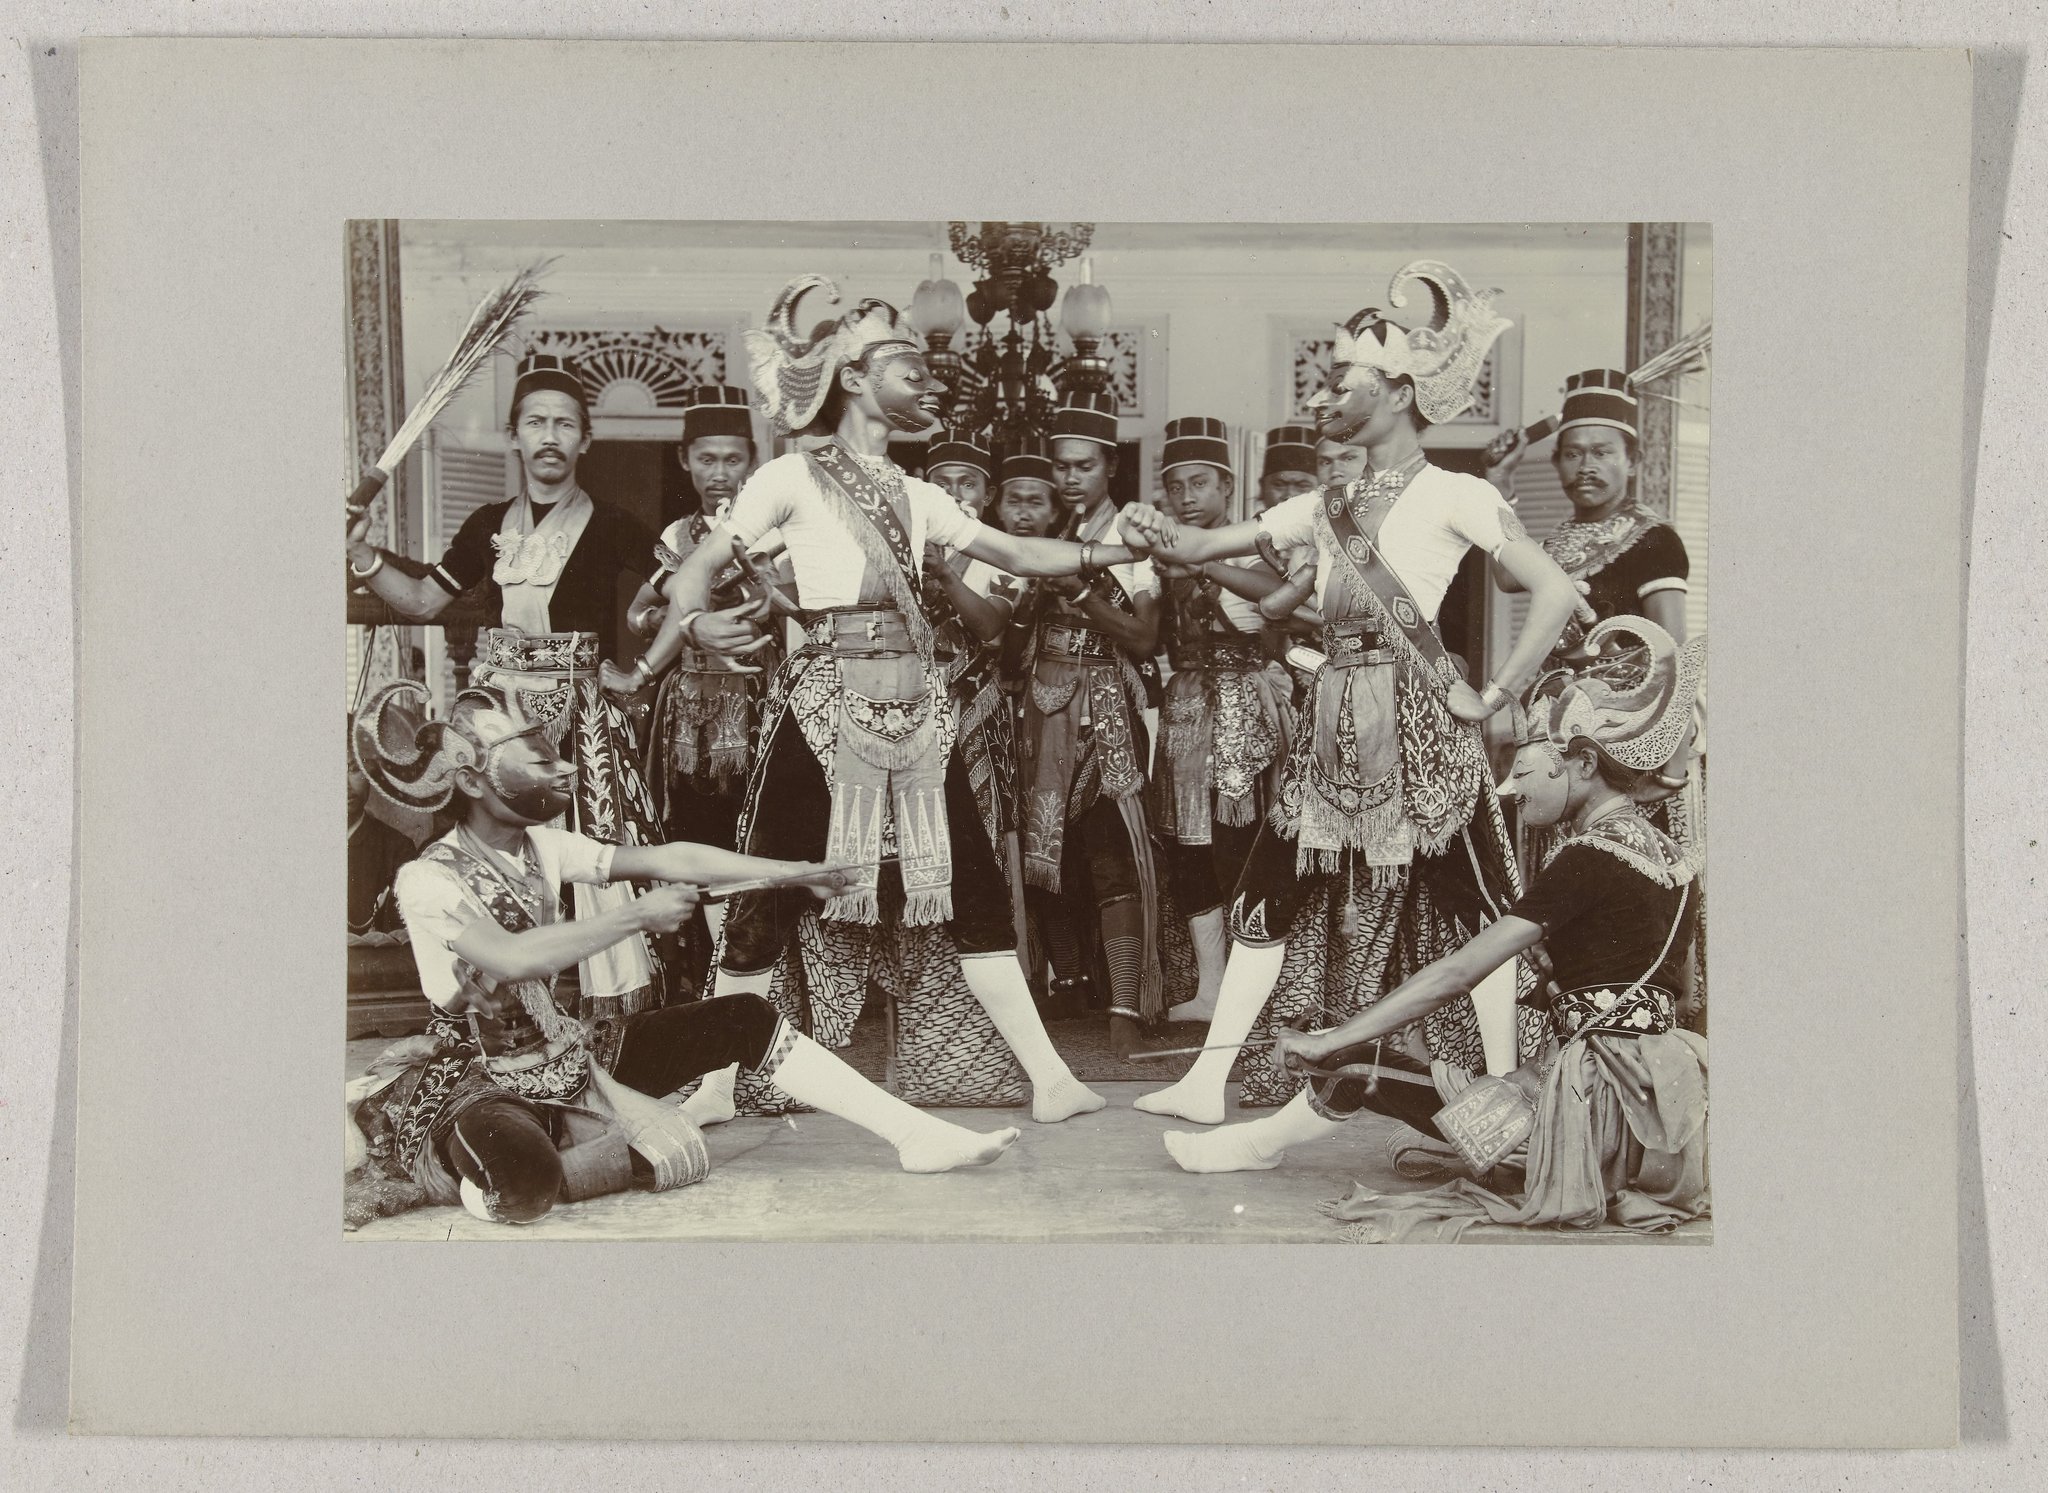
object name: photograph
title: Dansers met maskers in Nederlands-Indië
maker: Anonymous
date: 1895-1915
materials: cardboard, paper, photographic support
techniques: gelatin silver print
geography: dutch east indies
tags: indonesia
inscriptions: number: ‘39’